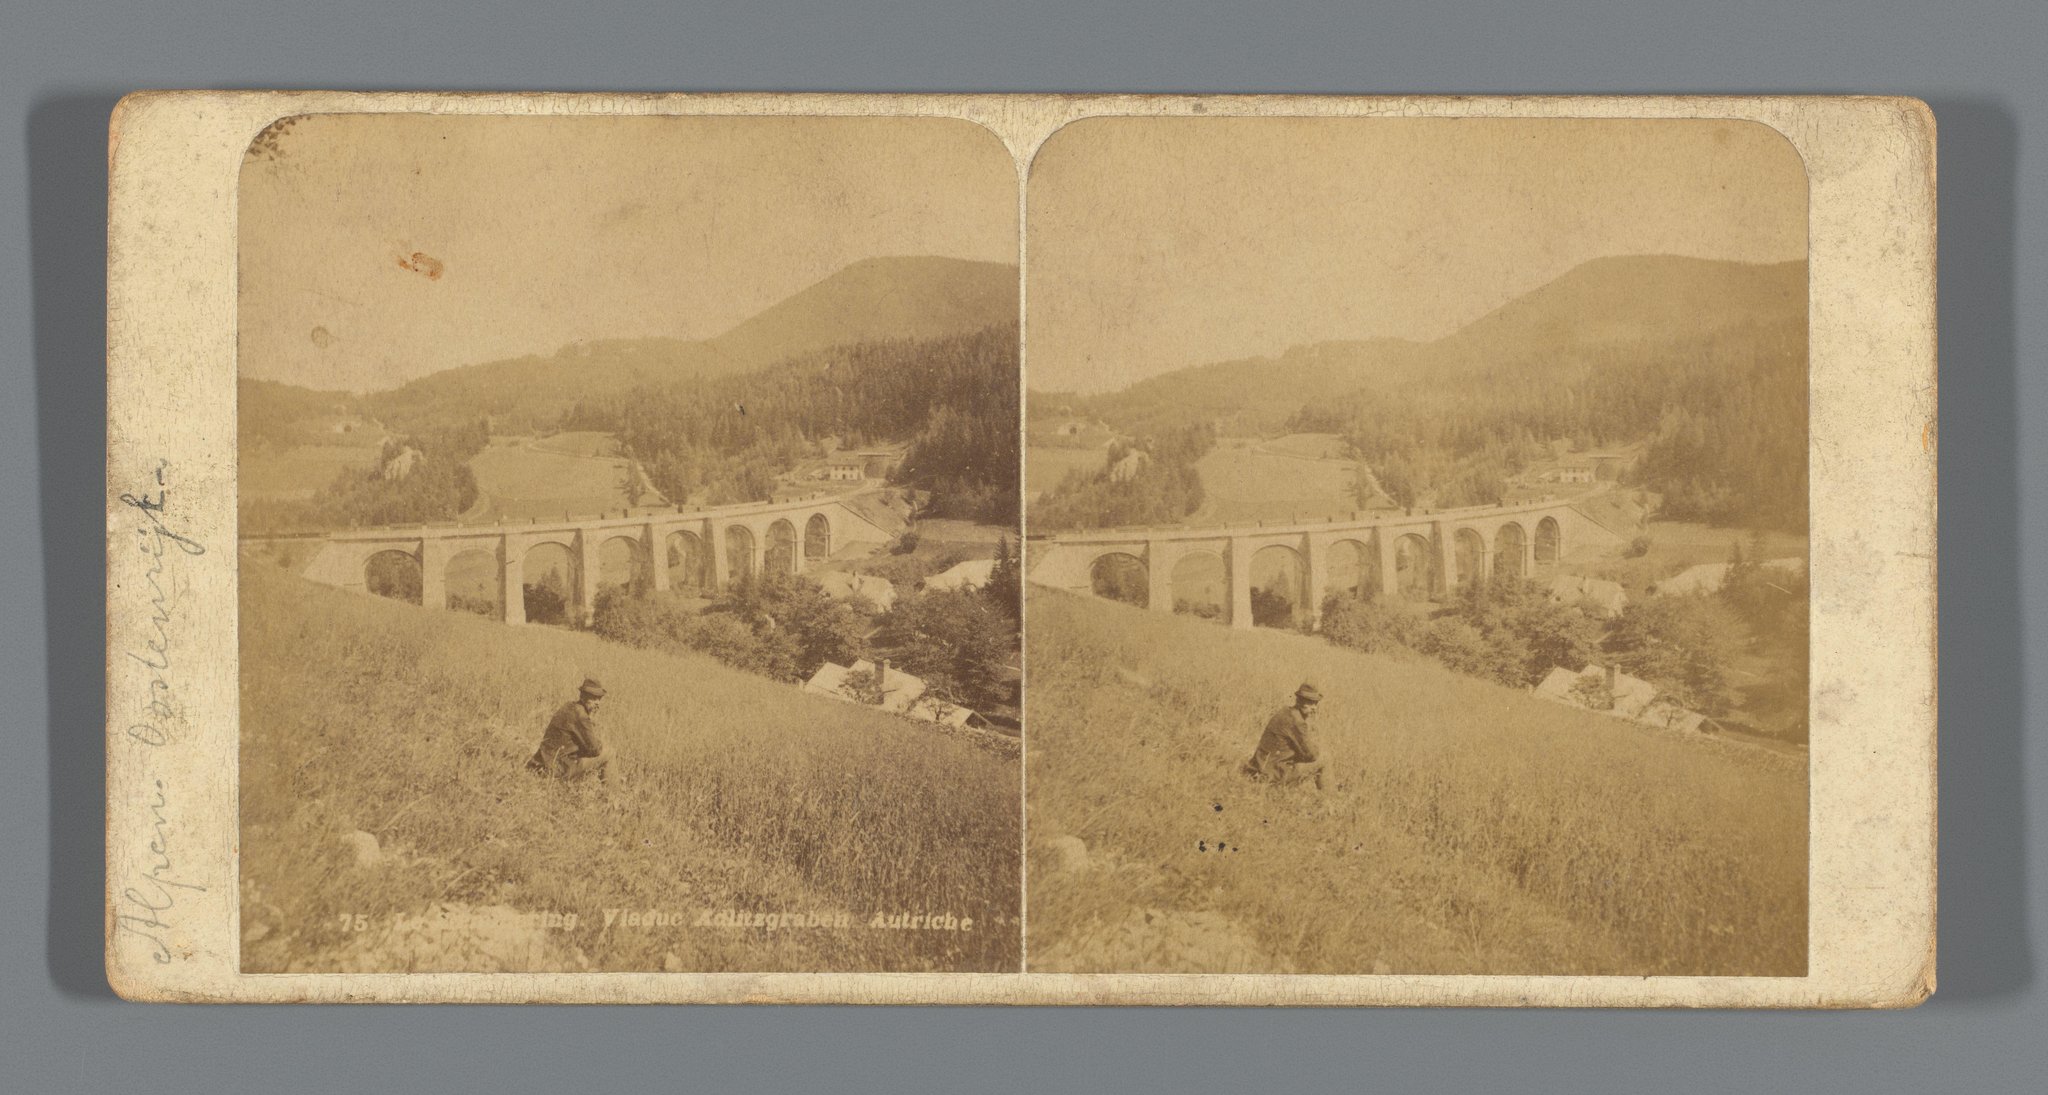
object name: stereograph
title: Aardrijkskundige Beeldengalerij, verzameld door M.J. Broekhuijsen, Hoofd eener school te Amsterdam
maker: martien johan broekhuijsen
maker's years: 1871-1956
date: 1905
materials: photographic support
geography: amsterdam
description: Onderdeel van een groep van 52 stereofoto's gebruikt in het lager onderwijs als aanvulling op schoolplaten. De gehele reeks bestond uit 274 nummers in 10 categorieën (A t/m K).